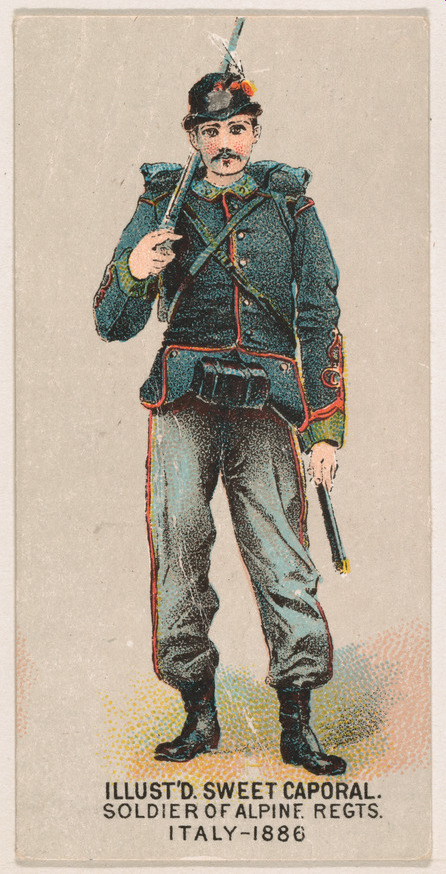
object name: print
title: Soldier of Alpine Regiments, Italy, 1886, from the Military Series (N224) issued by Kinney Tobacco Company to promote Sweet Caporal Cigarettes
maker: kinney brothers tobacco company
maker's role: publisher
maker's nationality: american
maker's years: 1869-2011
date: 1888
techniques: color lithograph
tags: military,weapons,men